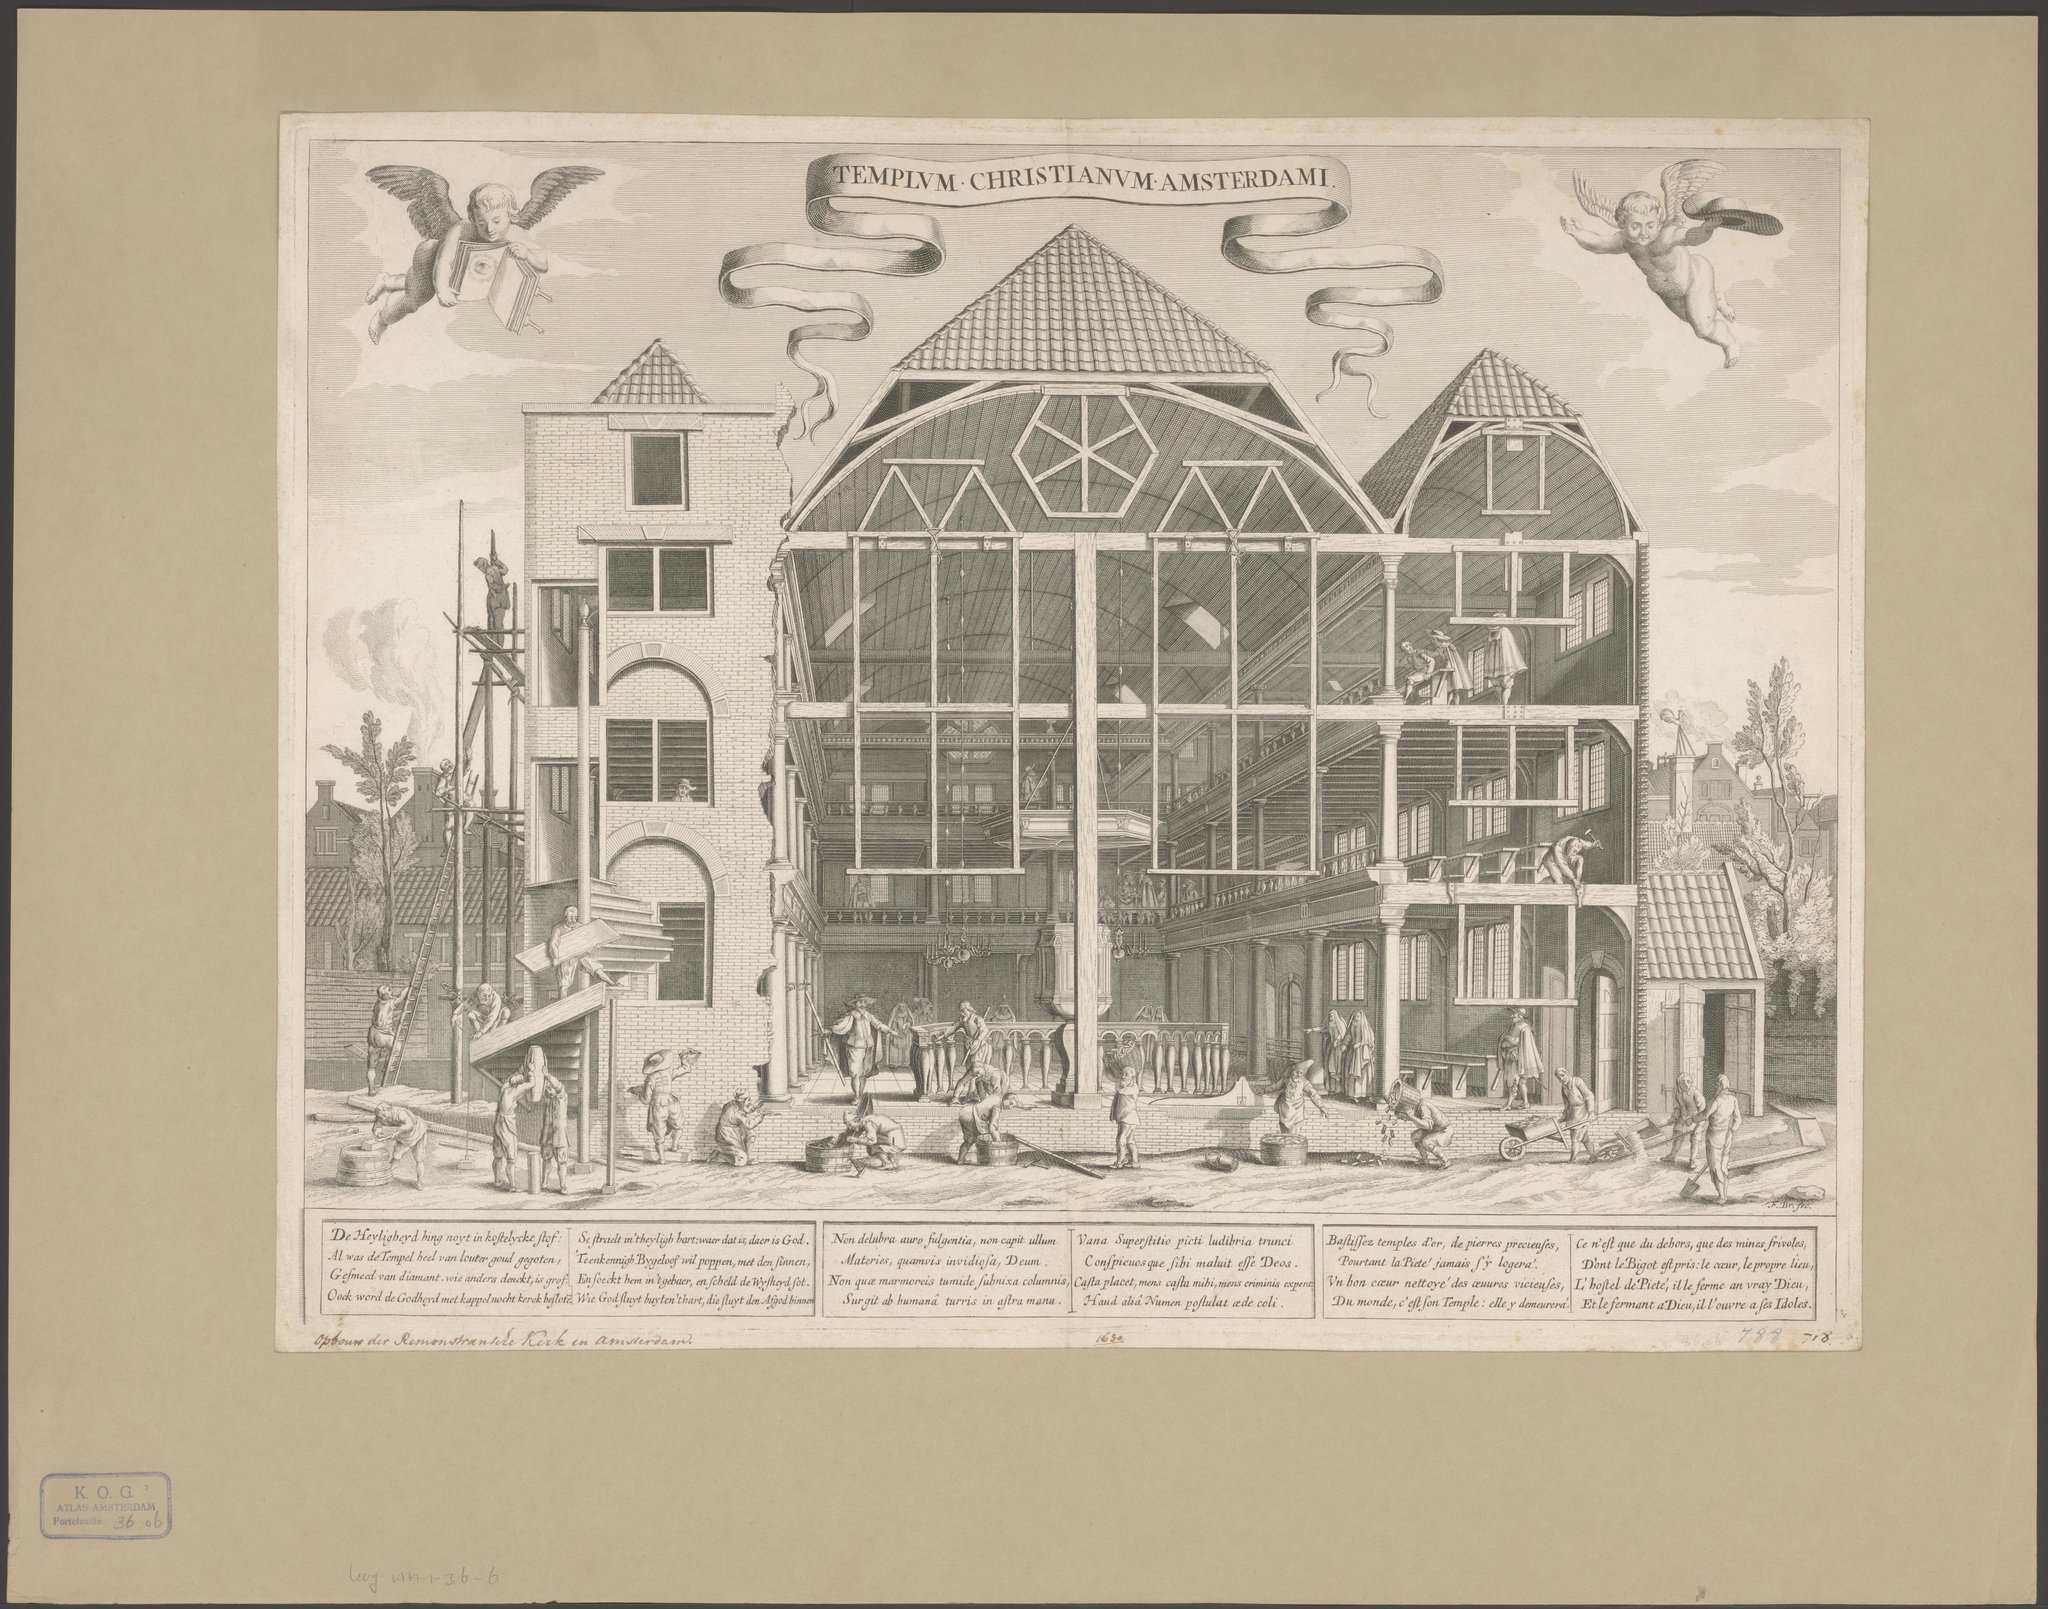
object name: print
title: Templum Christianum Amsterdam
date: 1630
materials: paper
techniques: engraving, etching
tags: building activities, protestant churches and denominations (with name), church (exterior), interior of church, building of church, amsterdam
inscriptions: collector's mark: Lugt 1641b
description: De Remonstrantse of Arminiaanse Kerk aan de Keizersgracht te Amsterdam in aanbouw. De kerk werd op 8 september 1630 ingewijd. De bouwwerkzaamheden aan de binnen- en buitenkant zijn in volle gang. Linksboven een putto met een bijbel met het alziend oog. Boven in het midden een banderol met de titel. Rechtsboven een putto met de vrijheidshoed. Onder de voorstelling drie verzen dan elk acht regels over twee kolommen in het Nederlands, Latijn en Frans. De Nederlandse versie is geschreven door Vondel. De Latijnse en Franse verzen zijn daar vertalingen van. Onderwerpsrubriek binnen de Atlas Amsterdam: Kerkwezen: Remonstrantse Gemeente.